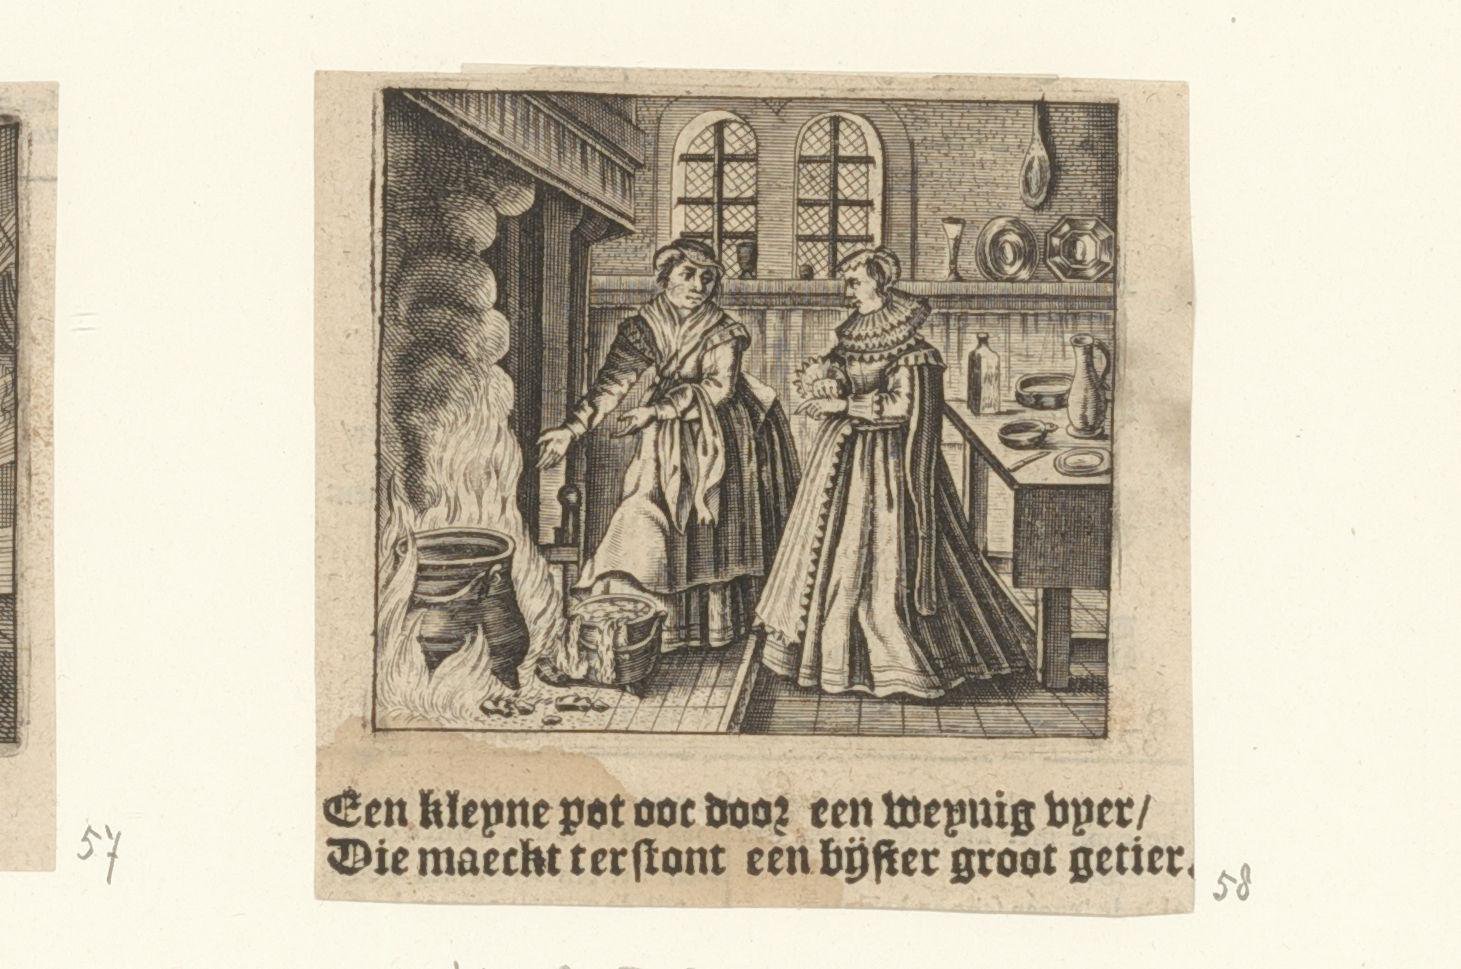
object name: print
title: Twee vrouwen kijken naar een ketel op het vuur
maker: Anonymous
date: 1635-1715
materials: paper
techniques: engraving, letterpress printing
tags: kitchen, proverbs, sayings, etc., kitchen-maid, kitchen servant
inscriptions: collector's mark: Lugt 1641, stamp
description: Veel versies van dit embleem verschenen in verschillende uitgave van Spiegel van den Ouden ende Nieuwen Tydt. Zoals: Cats, Jacob. Spiegel van den Ouden ende Nieuwen-tijt, Bestaende uyt Spreeck-woorden (...). Dordrecht: Jacob Braat, 1647. Maar ook in andere publicaties (1665, 1671, 1715, 1722).